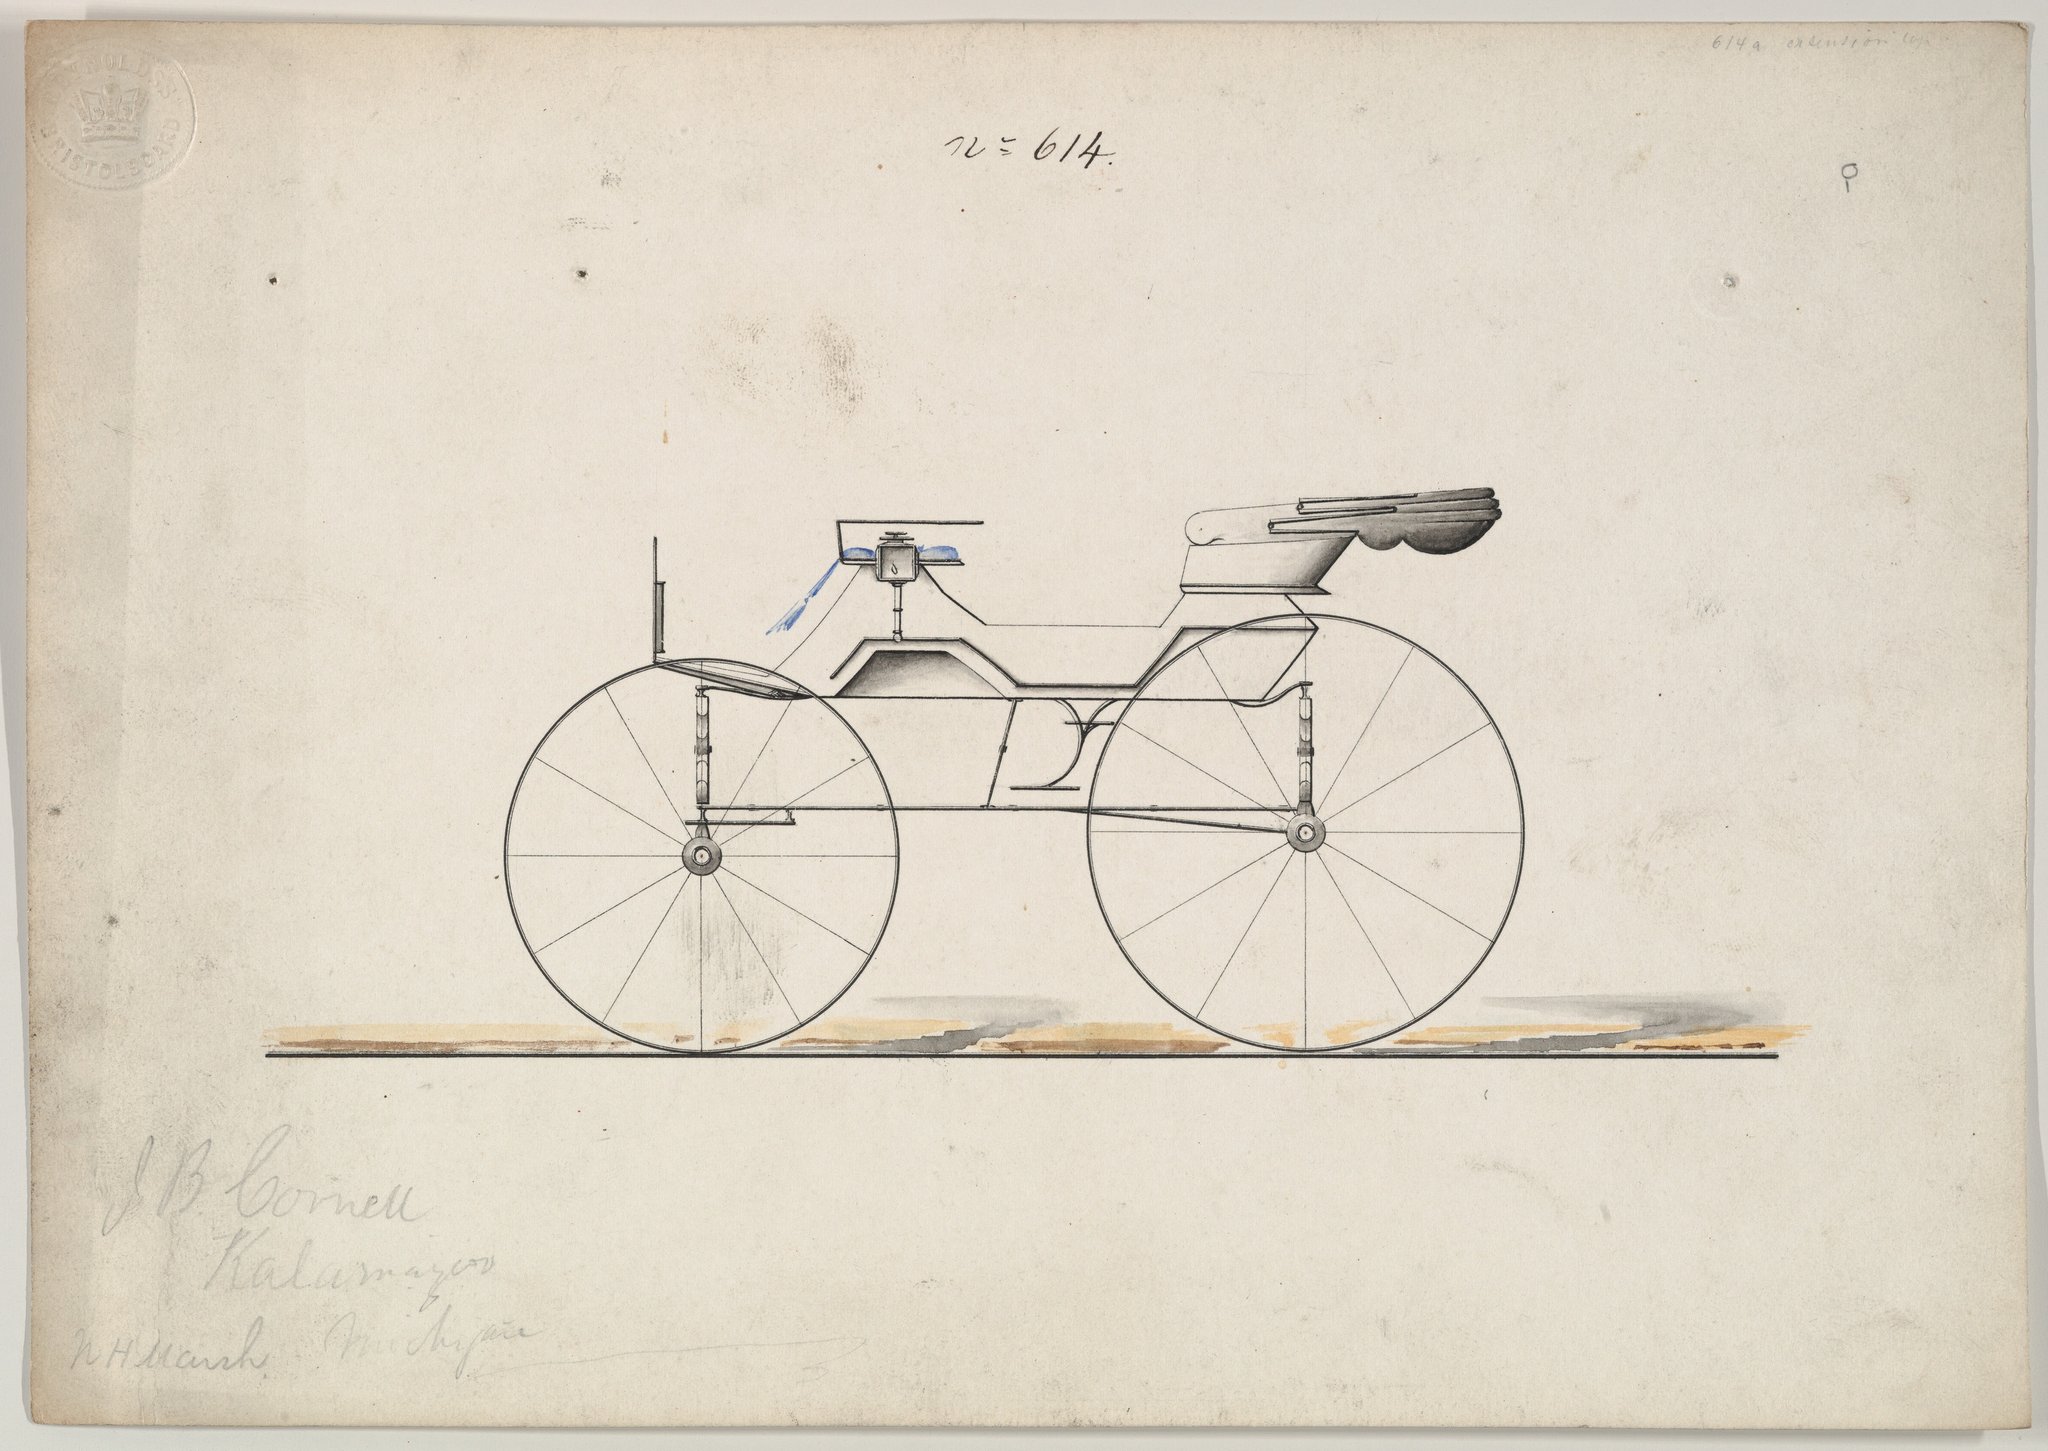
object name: drawing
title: Design for Phaeton, no. 614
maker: brewster & co.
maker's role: manufacturer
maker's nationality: american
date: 1850-1874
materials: gouache, graphite, ink, watercolor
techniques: pen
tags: carriages